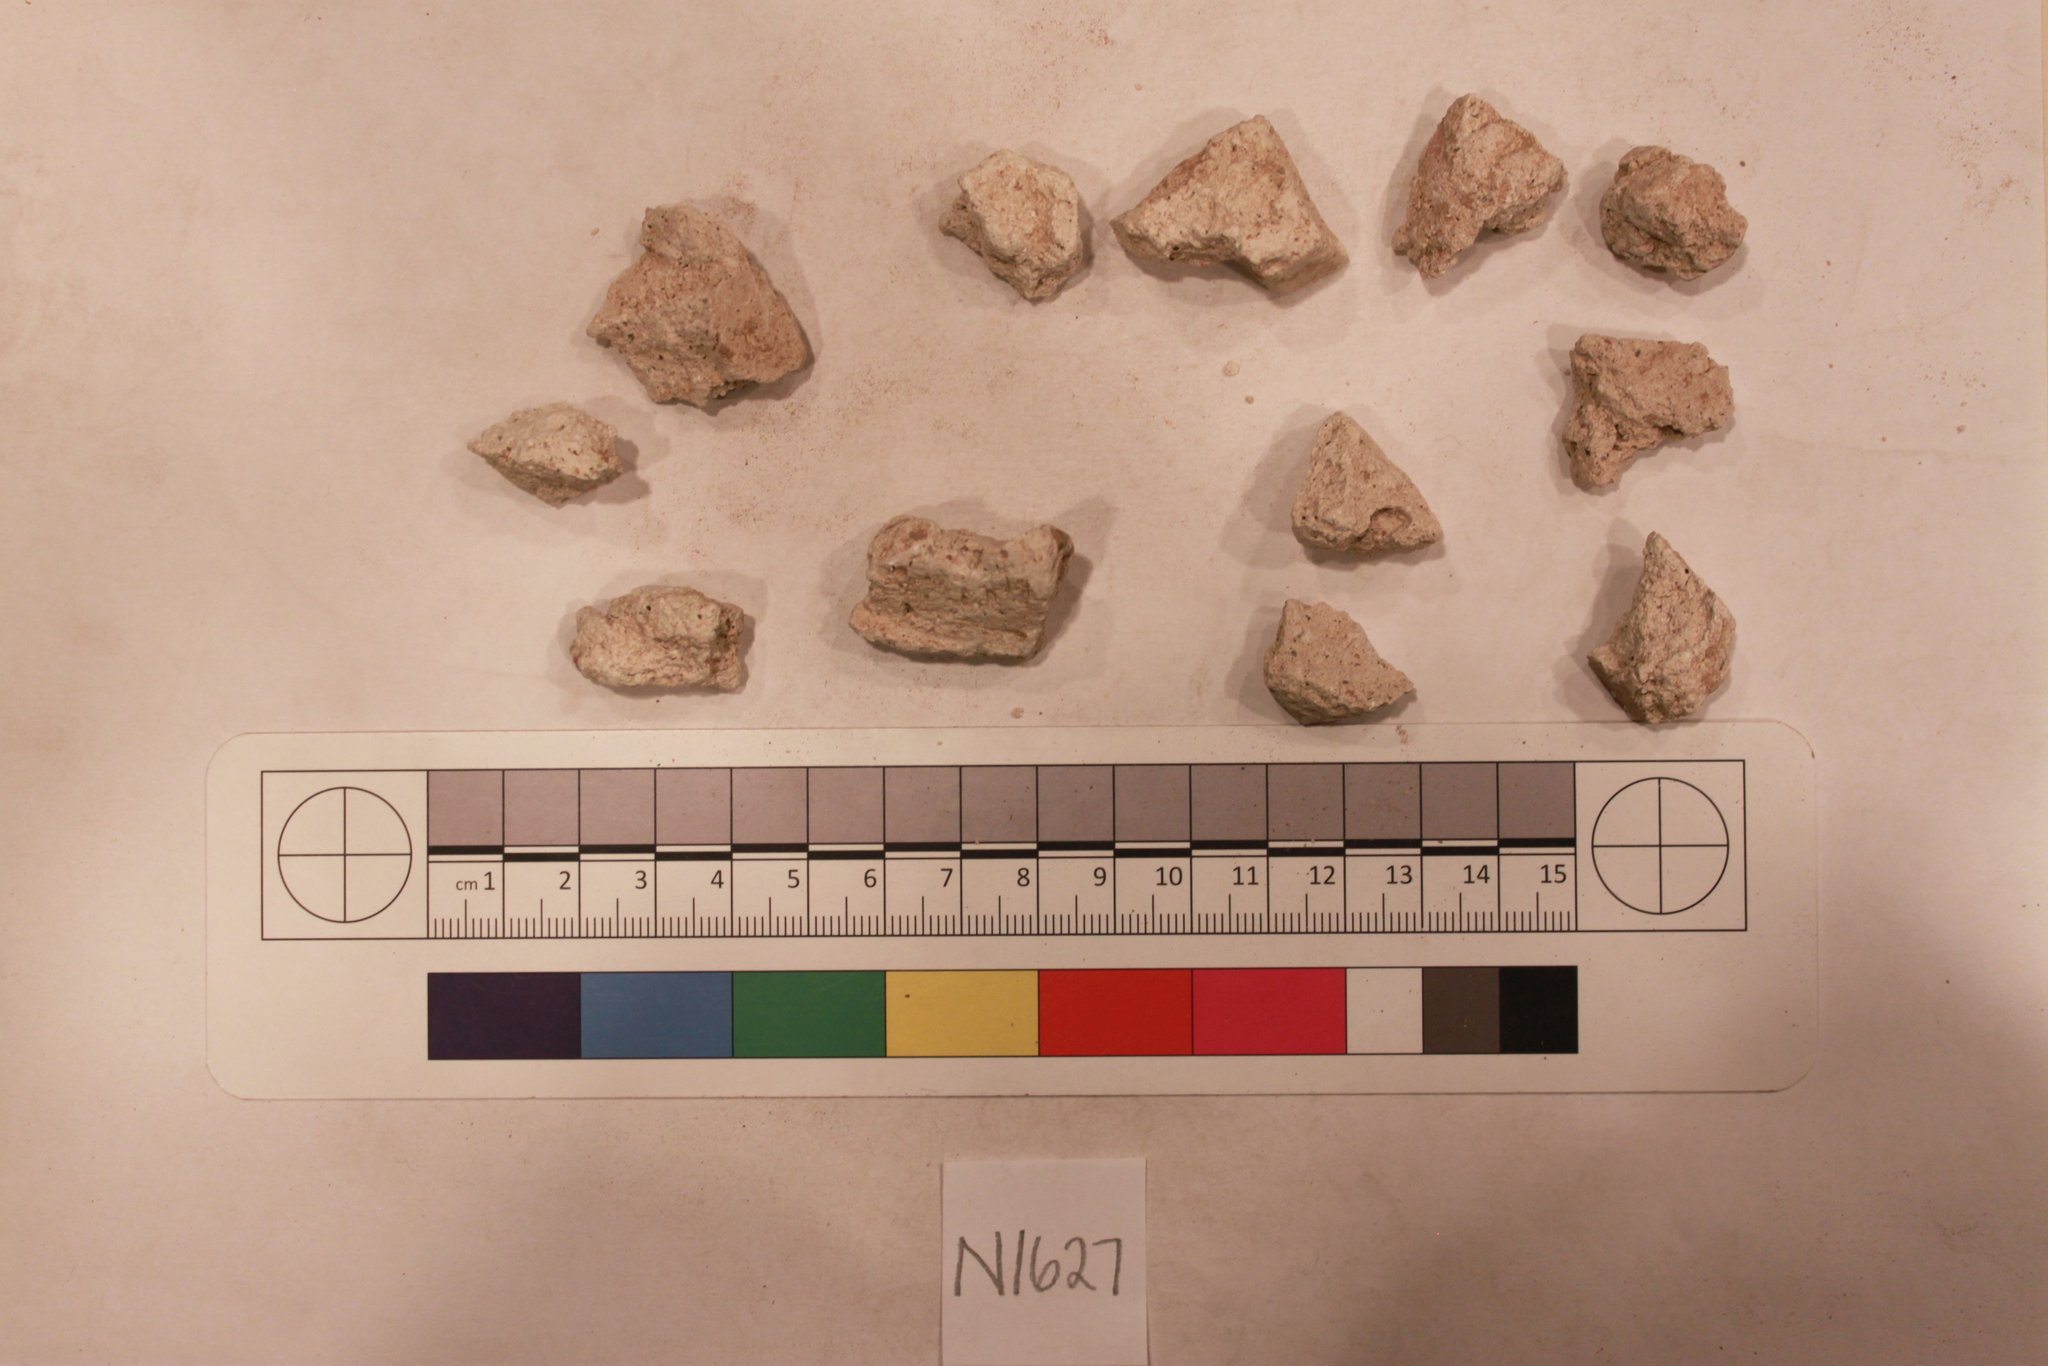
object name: fragment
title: Stucco Fragment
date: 701-1200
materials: plaster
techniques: carving, painting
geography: iran